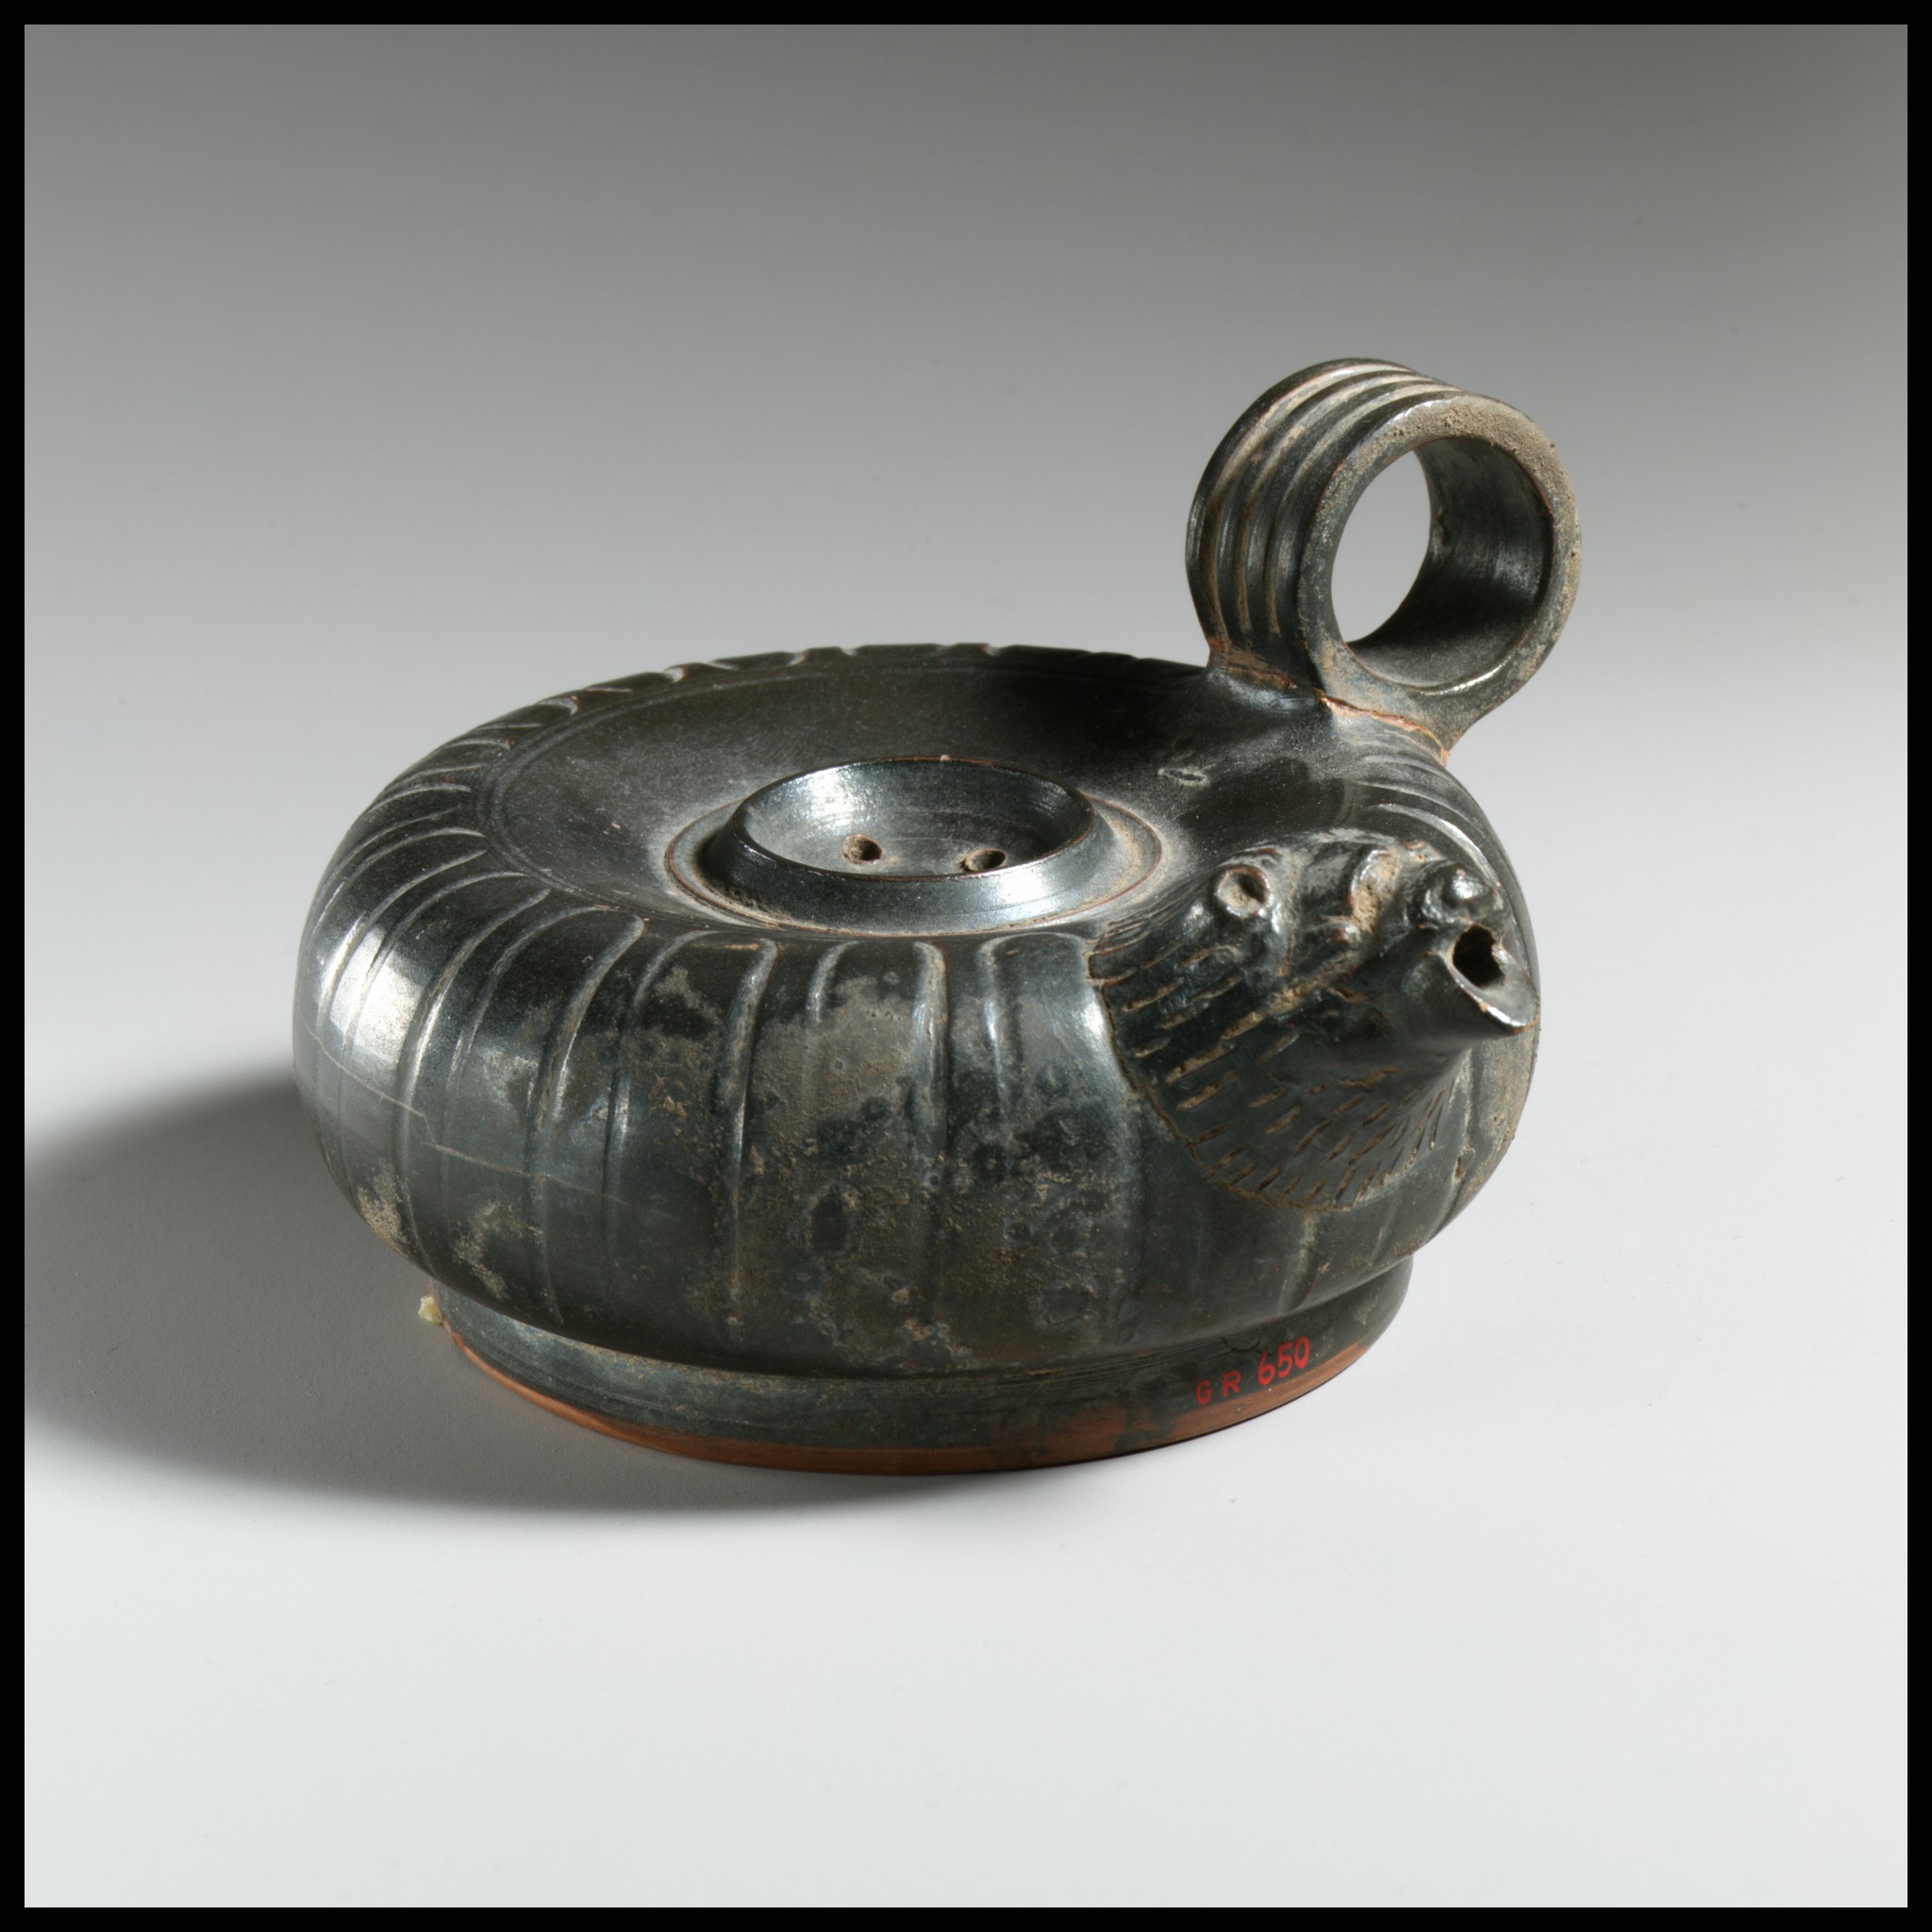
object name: guttus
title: Terracotta guttus (flask with handle and spout)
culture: greek or south italian or campanian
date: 400-301 BCE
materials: terracotta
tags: lions